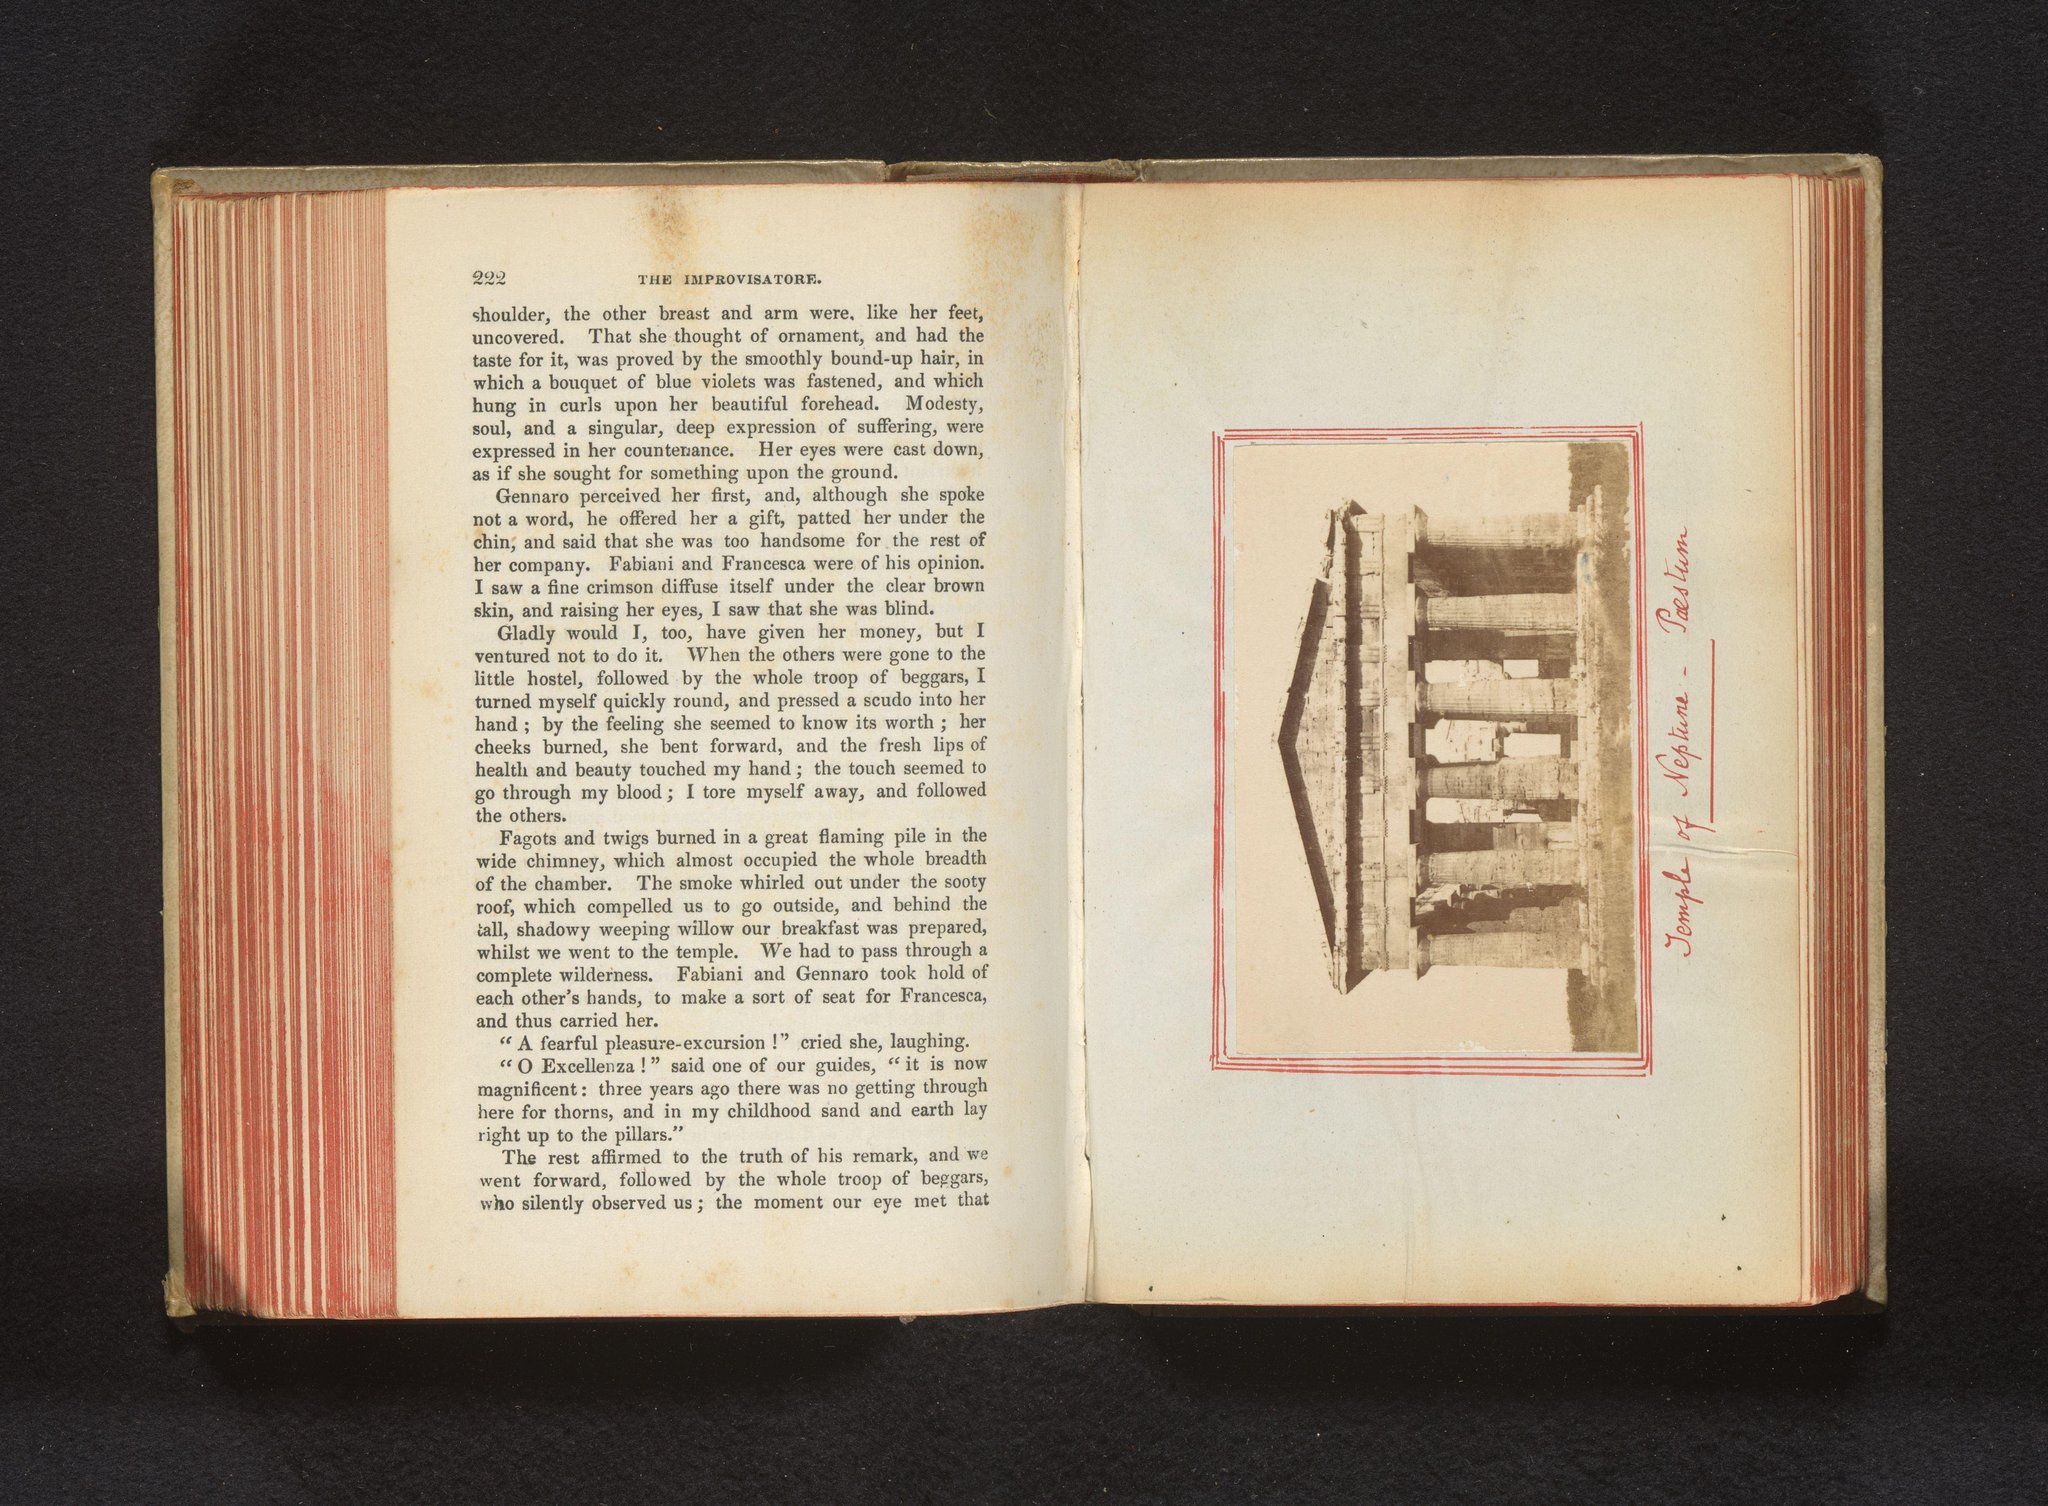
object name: page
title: Temple of Neptune - Paestum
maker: Anonymous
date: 1863-1873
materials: photographic support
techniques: albumen print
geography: paestum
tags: façade (of house or building), temple, shrine ~ greek religion